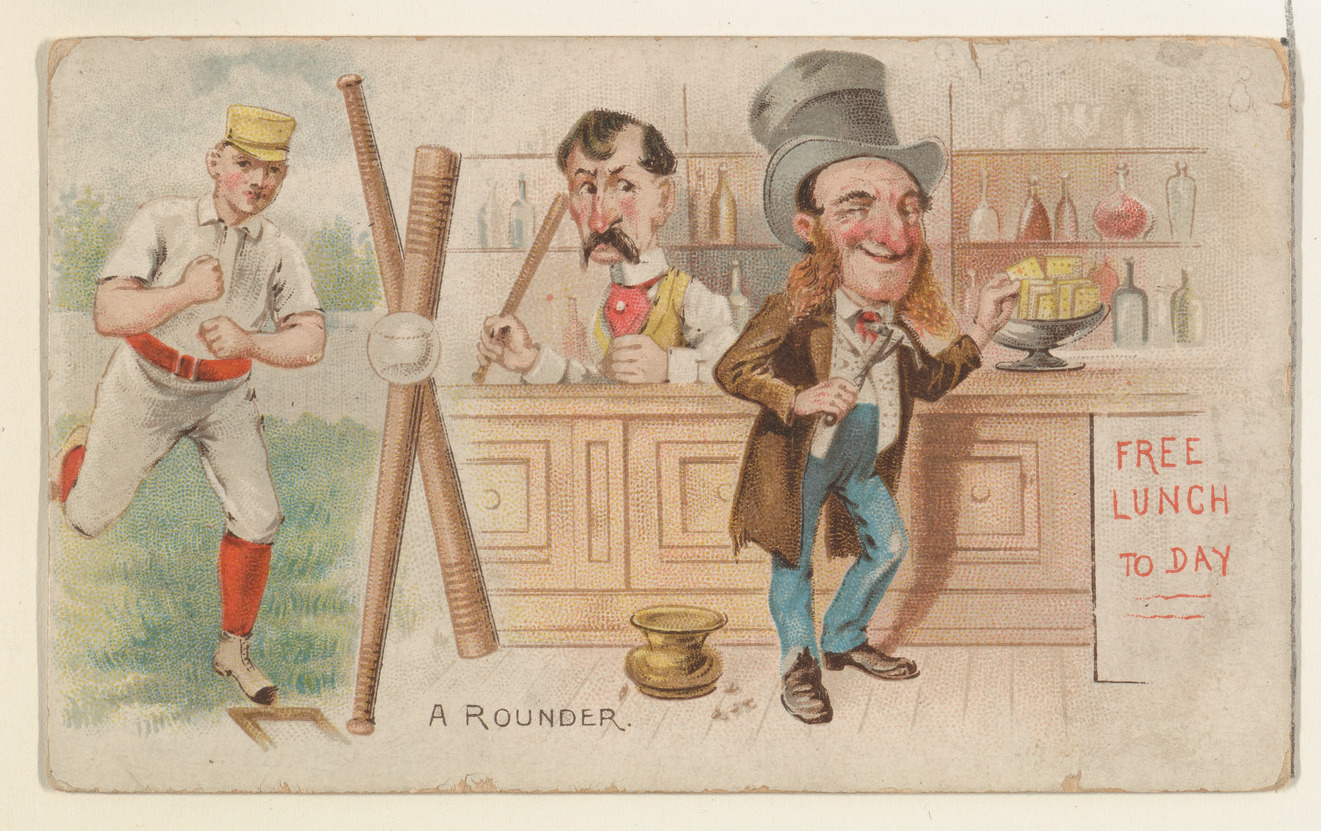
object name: print, baseball card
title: A Rounder, from the Talk of the Diamond set (N135) issued by Duke Sons & Co., a branch of the American Tobacco Company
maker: w. duke, sons & co.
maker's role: publisher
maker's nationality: american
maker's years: 1870-1920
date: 1888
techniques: color lithograph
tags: men,baseball,athletes